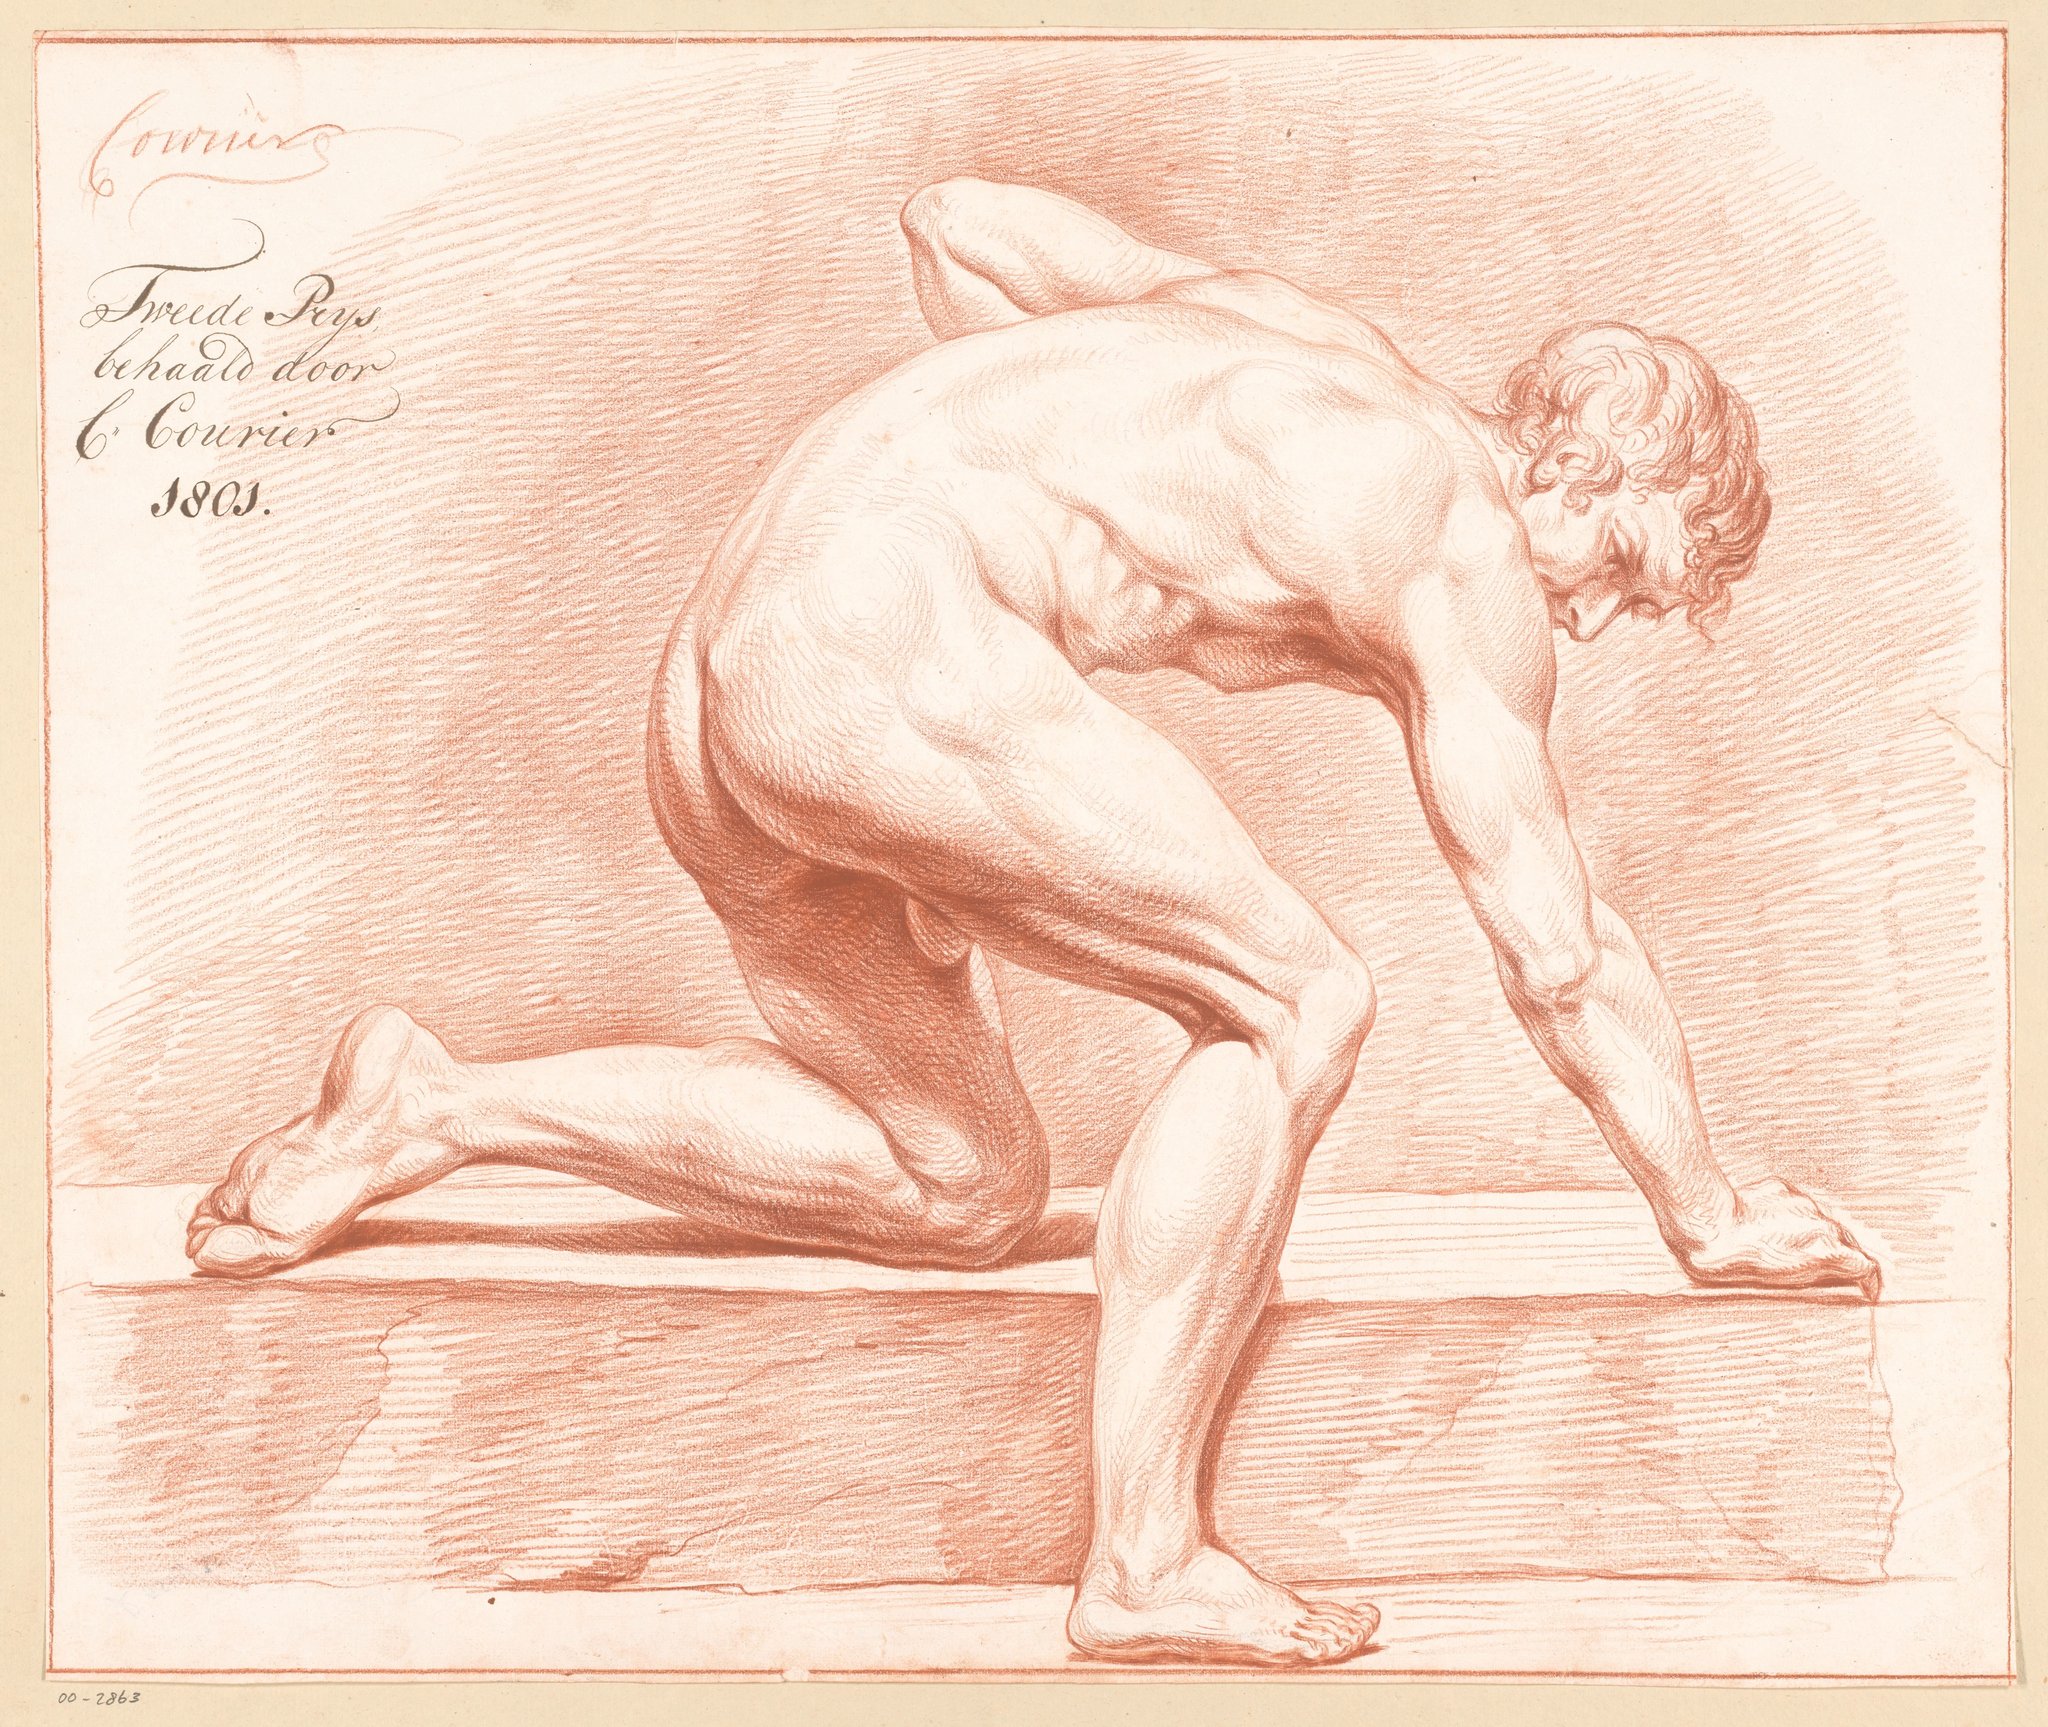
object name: drawing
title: Knielend mannelijk naakt, van opzij gezien (2e prijs 1801)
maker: c. courier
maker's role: draughtsman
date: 1801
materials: chalk, charcoal, paper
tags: kneeling figure (+ nude human being)